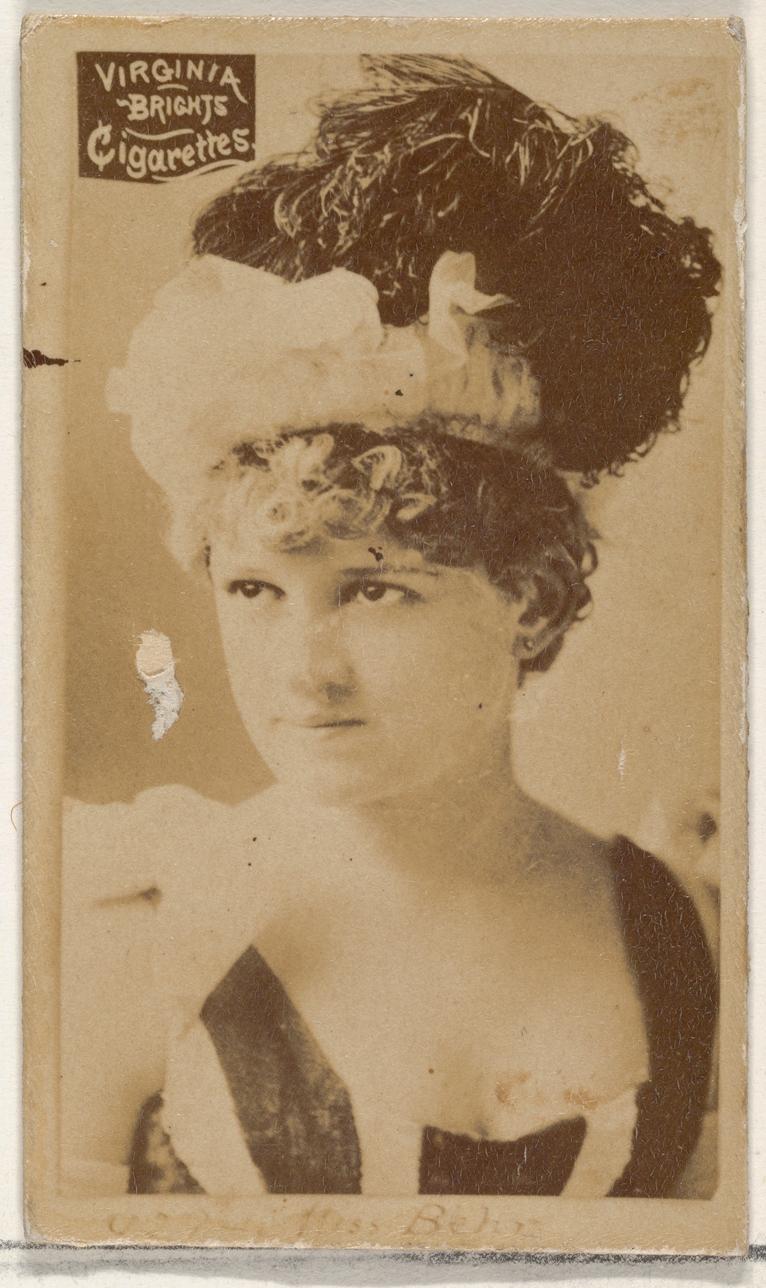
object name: photograph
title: Miss Behr, from the Actors and Actresses series (N45, Type 2) for Virginia Brights Cigarettes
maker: allen & ginter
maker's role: publisher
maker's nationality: american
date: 1888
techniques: albumen silver print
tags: portraits,women,actresses